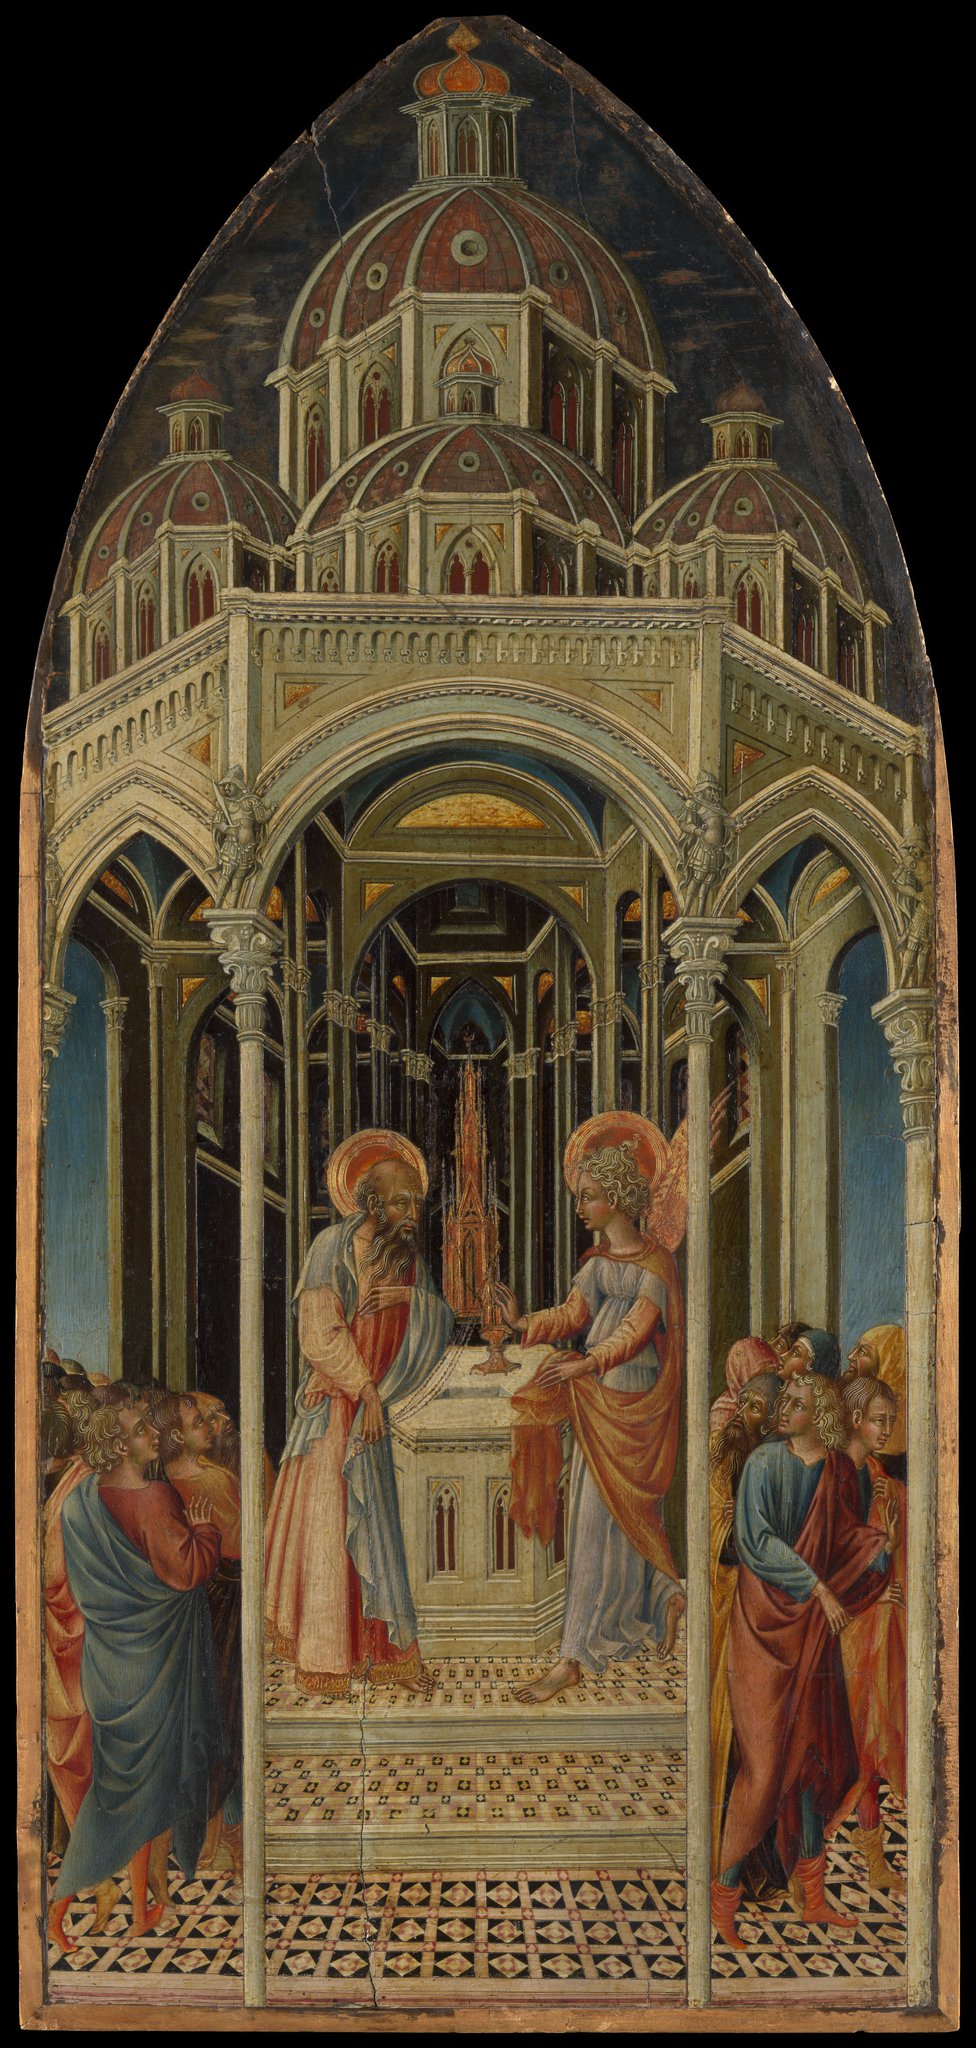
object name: painting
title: The Annunciation to Zacharias; (verso) The Angel of the Annunciation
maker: giovanni di paolo (giovanni di paolo di grazia)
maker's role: artist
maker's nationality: italian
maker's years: 1398-1482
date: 1455-1460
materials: gold, paint, wood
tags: men,angels,saint john the baptist,annunciation